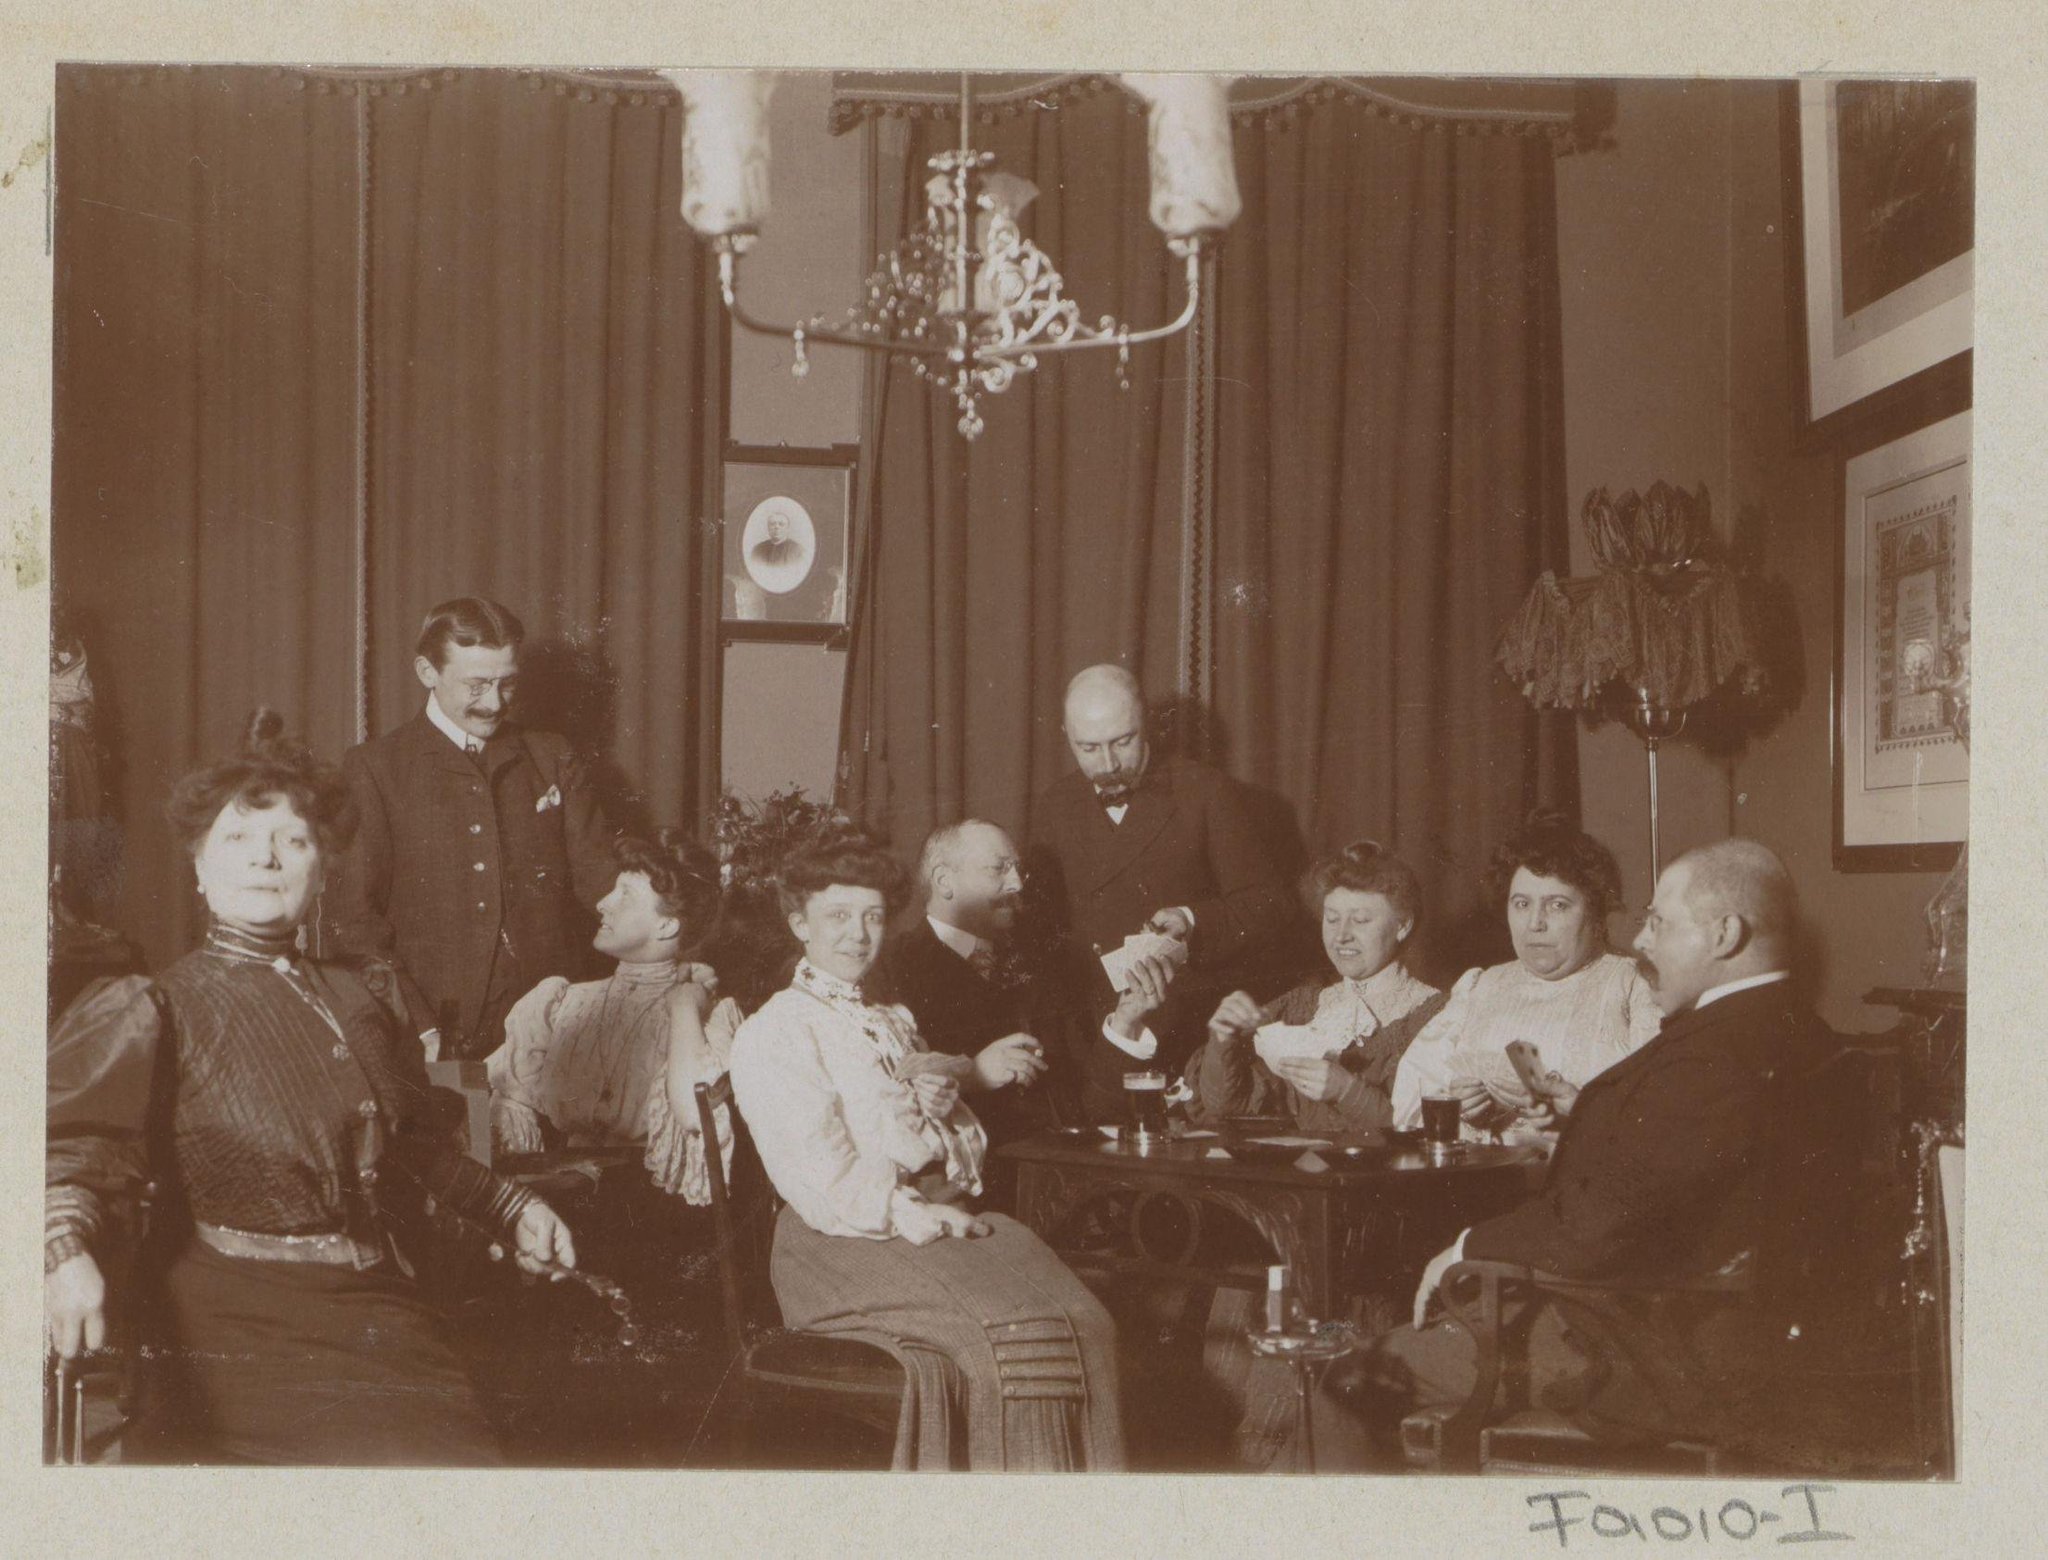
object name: photograph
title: Kaartend gezelschap om een tafel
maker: Anonymous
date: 1900-1910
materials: photographic support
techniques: daylight paper print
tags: card games, interior of the house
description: Onderdeel van Familiealbum met onder meer foto's van Wijnhandel Kraaij & Co. Bordeaux-Amsterdam.